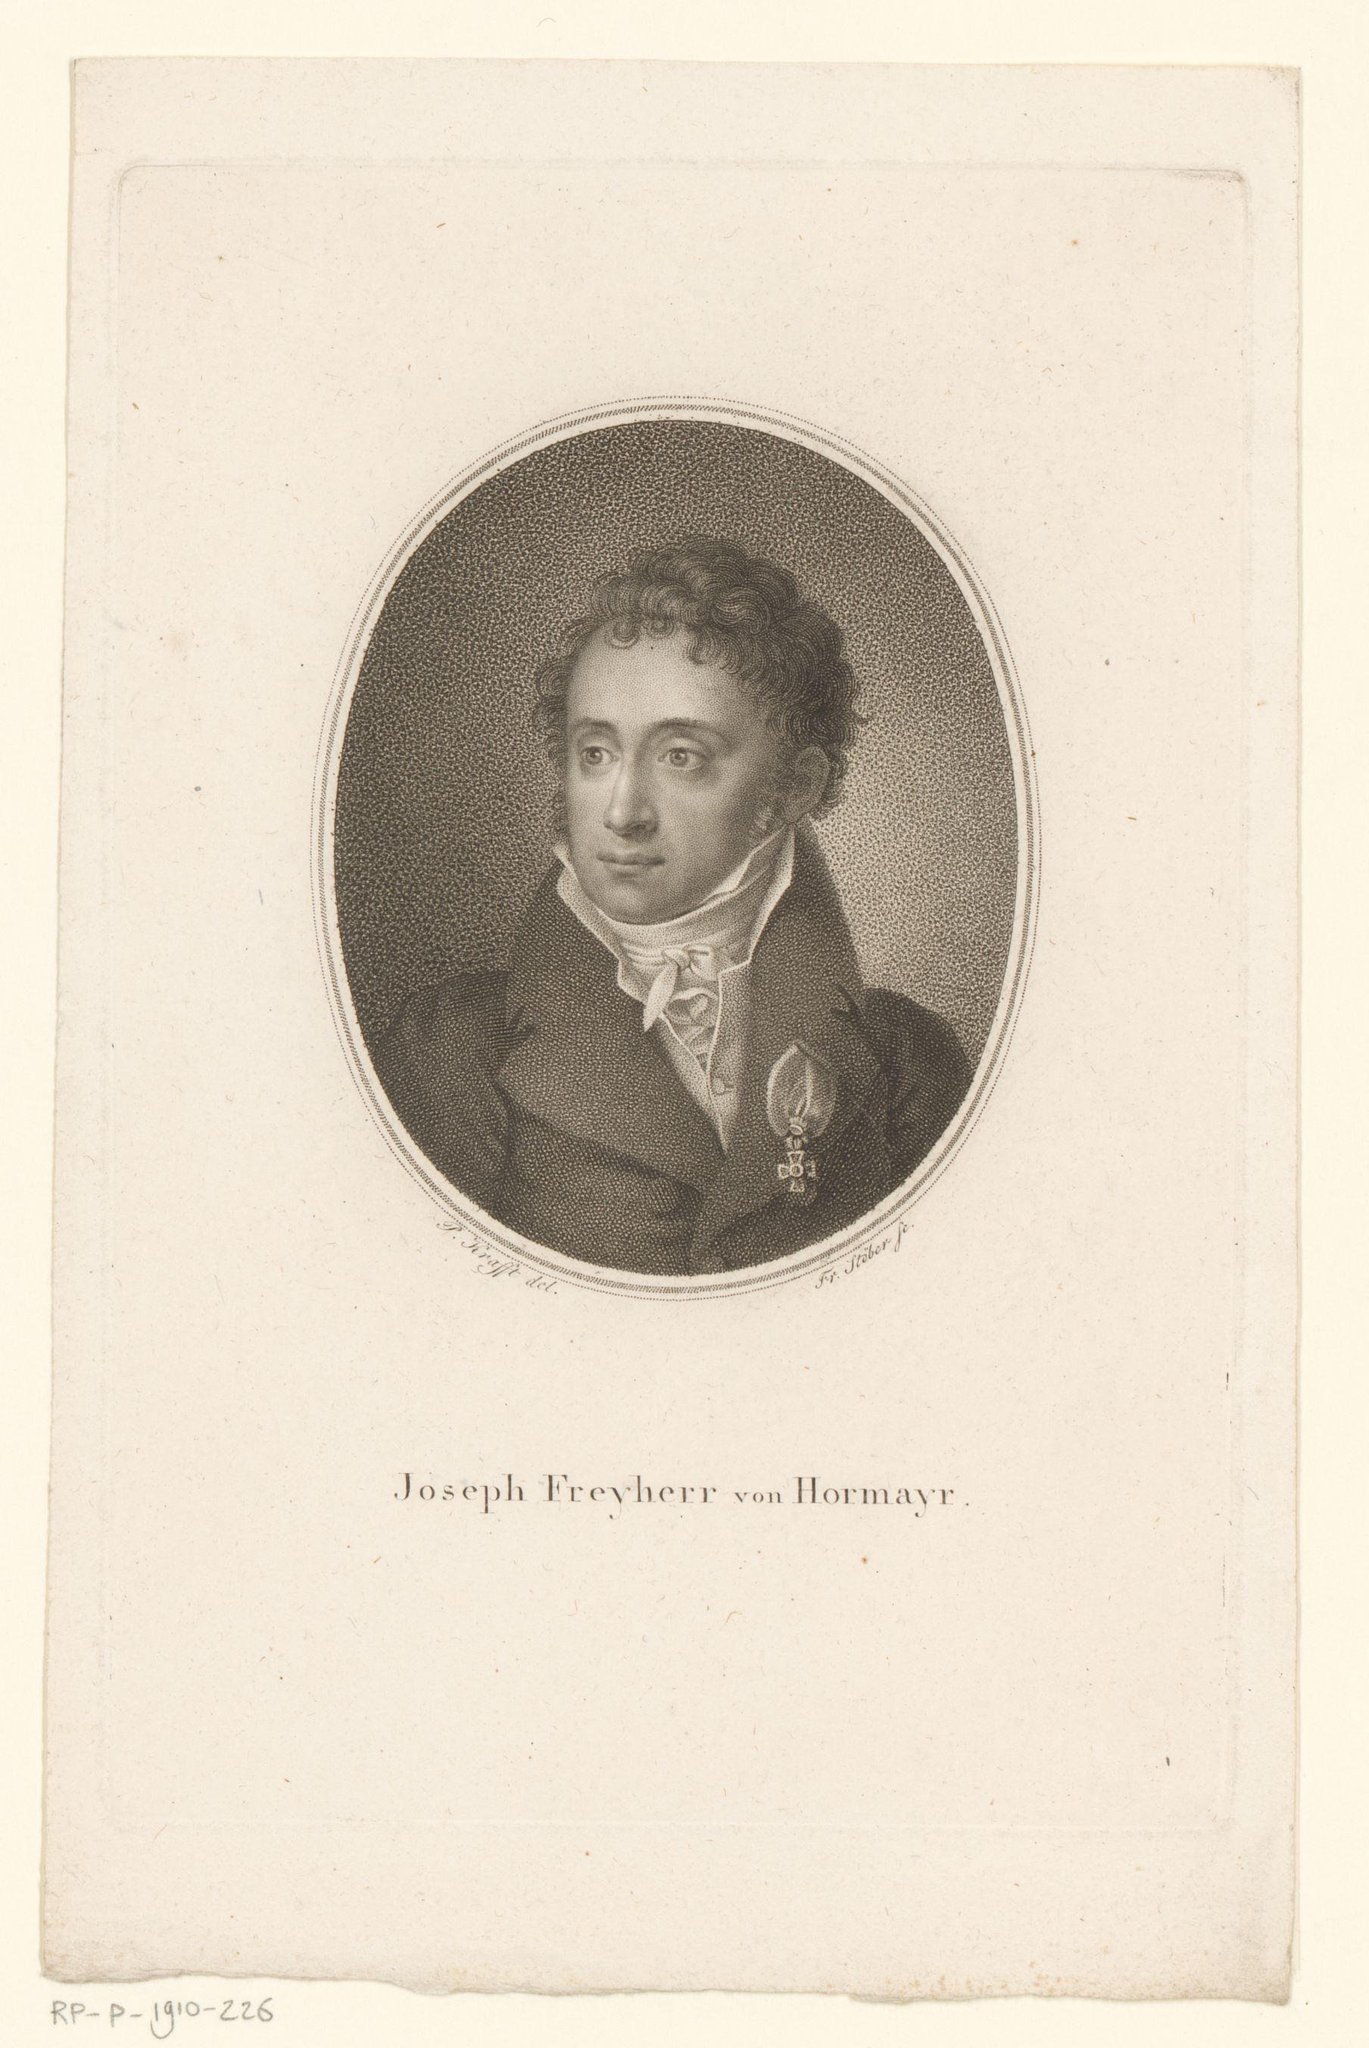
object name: print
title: Portret van Joseph von Hormayr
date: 1810-1858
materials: paper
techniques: engraving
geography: vienna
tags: historical persons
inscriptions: collector's mark: Lugt 2228